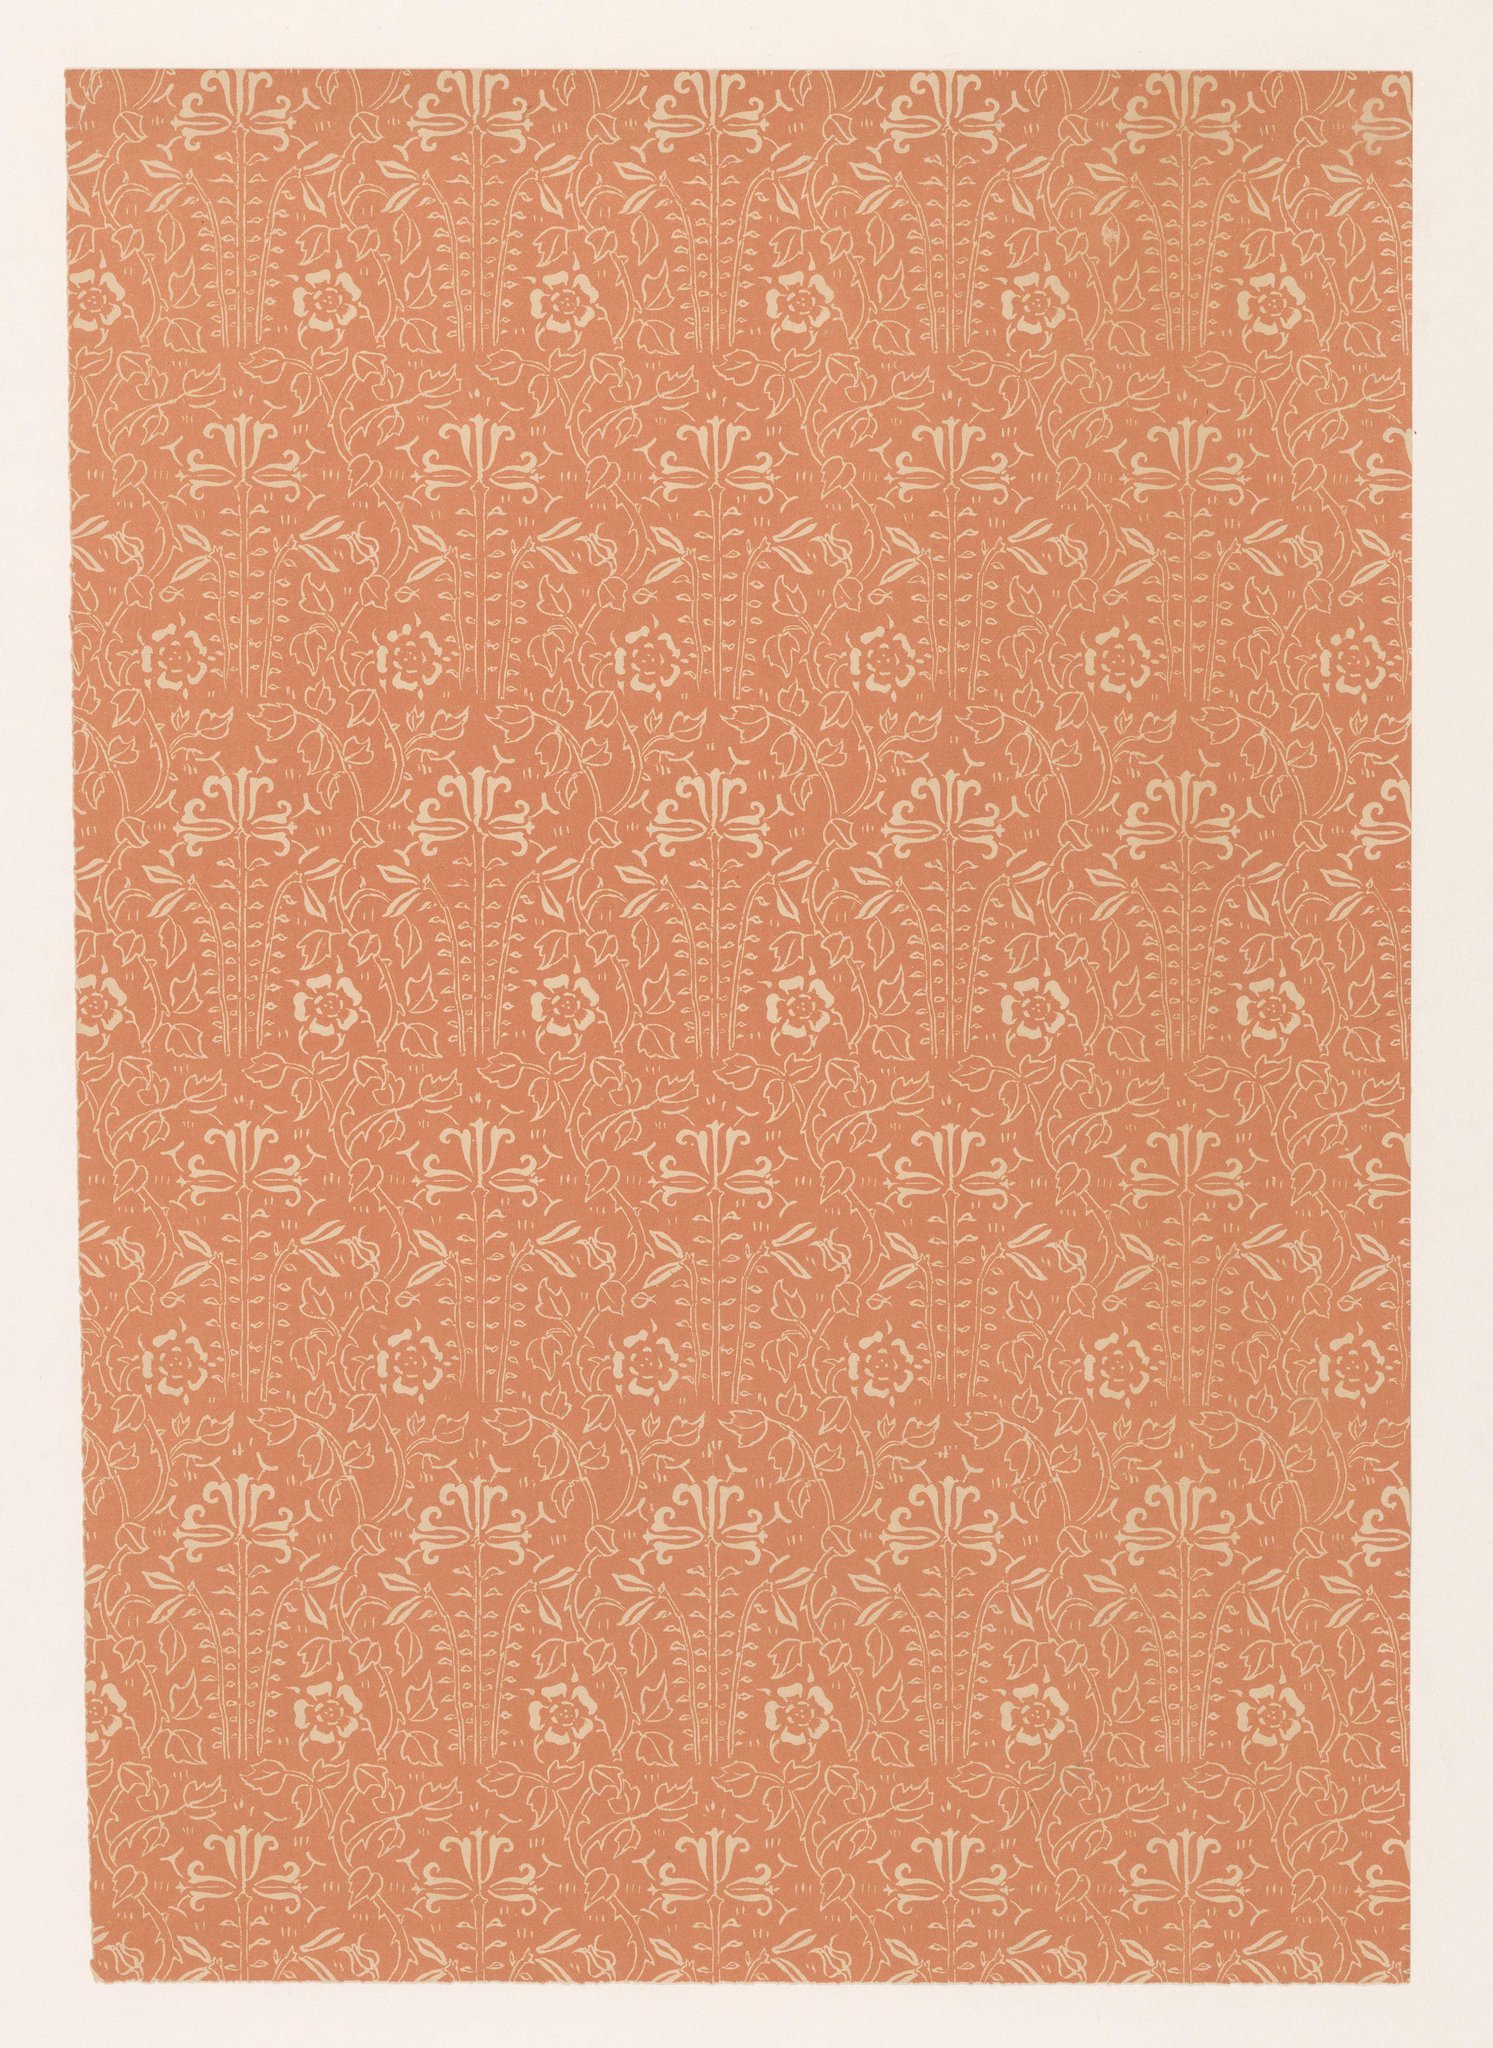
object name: decorated paper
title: Blad met banenpatroon van bloemen met bladeren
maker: Anonymous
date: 1900-1920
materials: ink, paper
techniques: lithograph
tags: ornament derived from plant forms